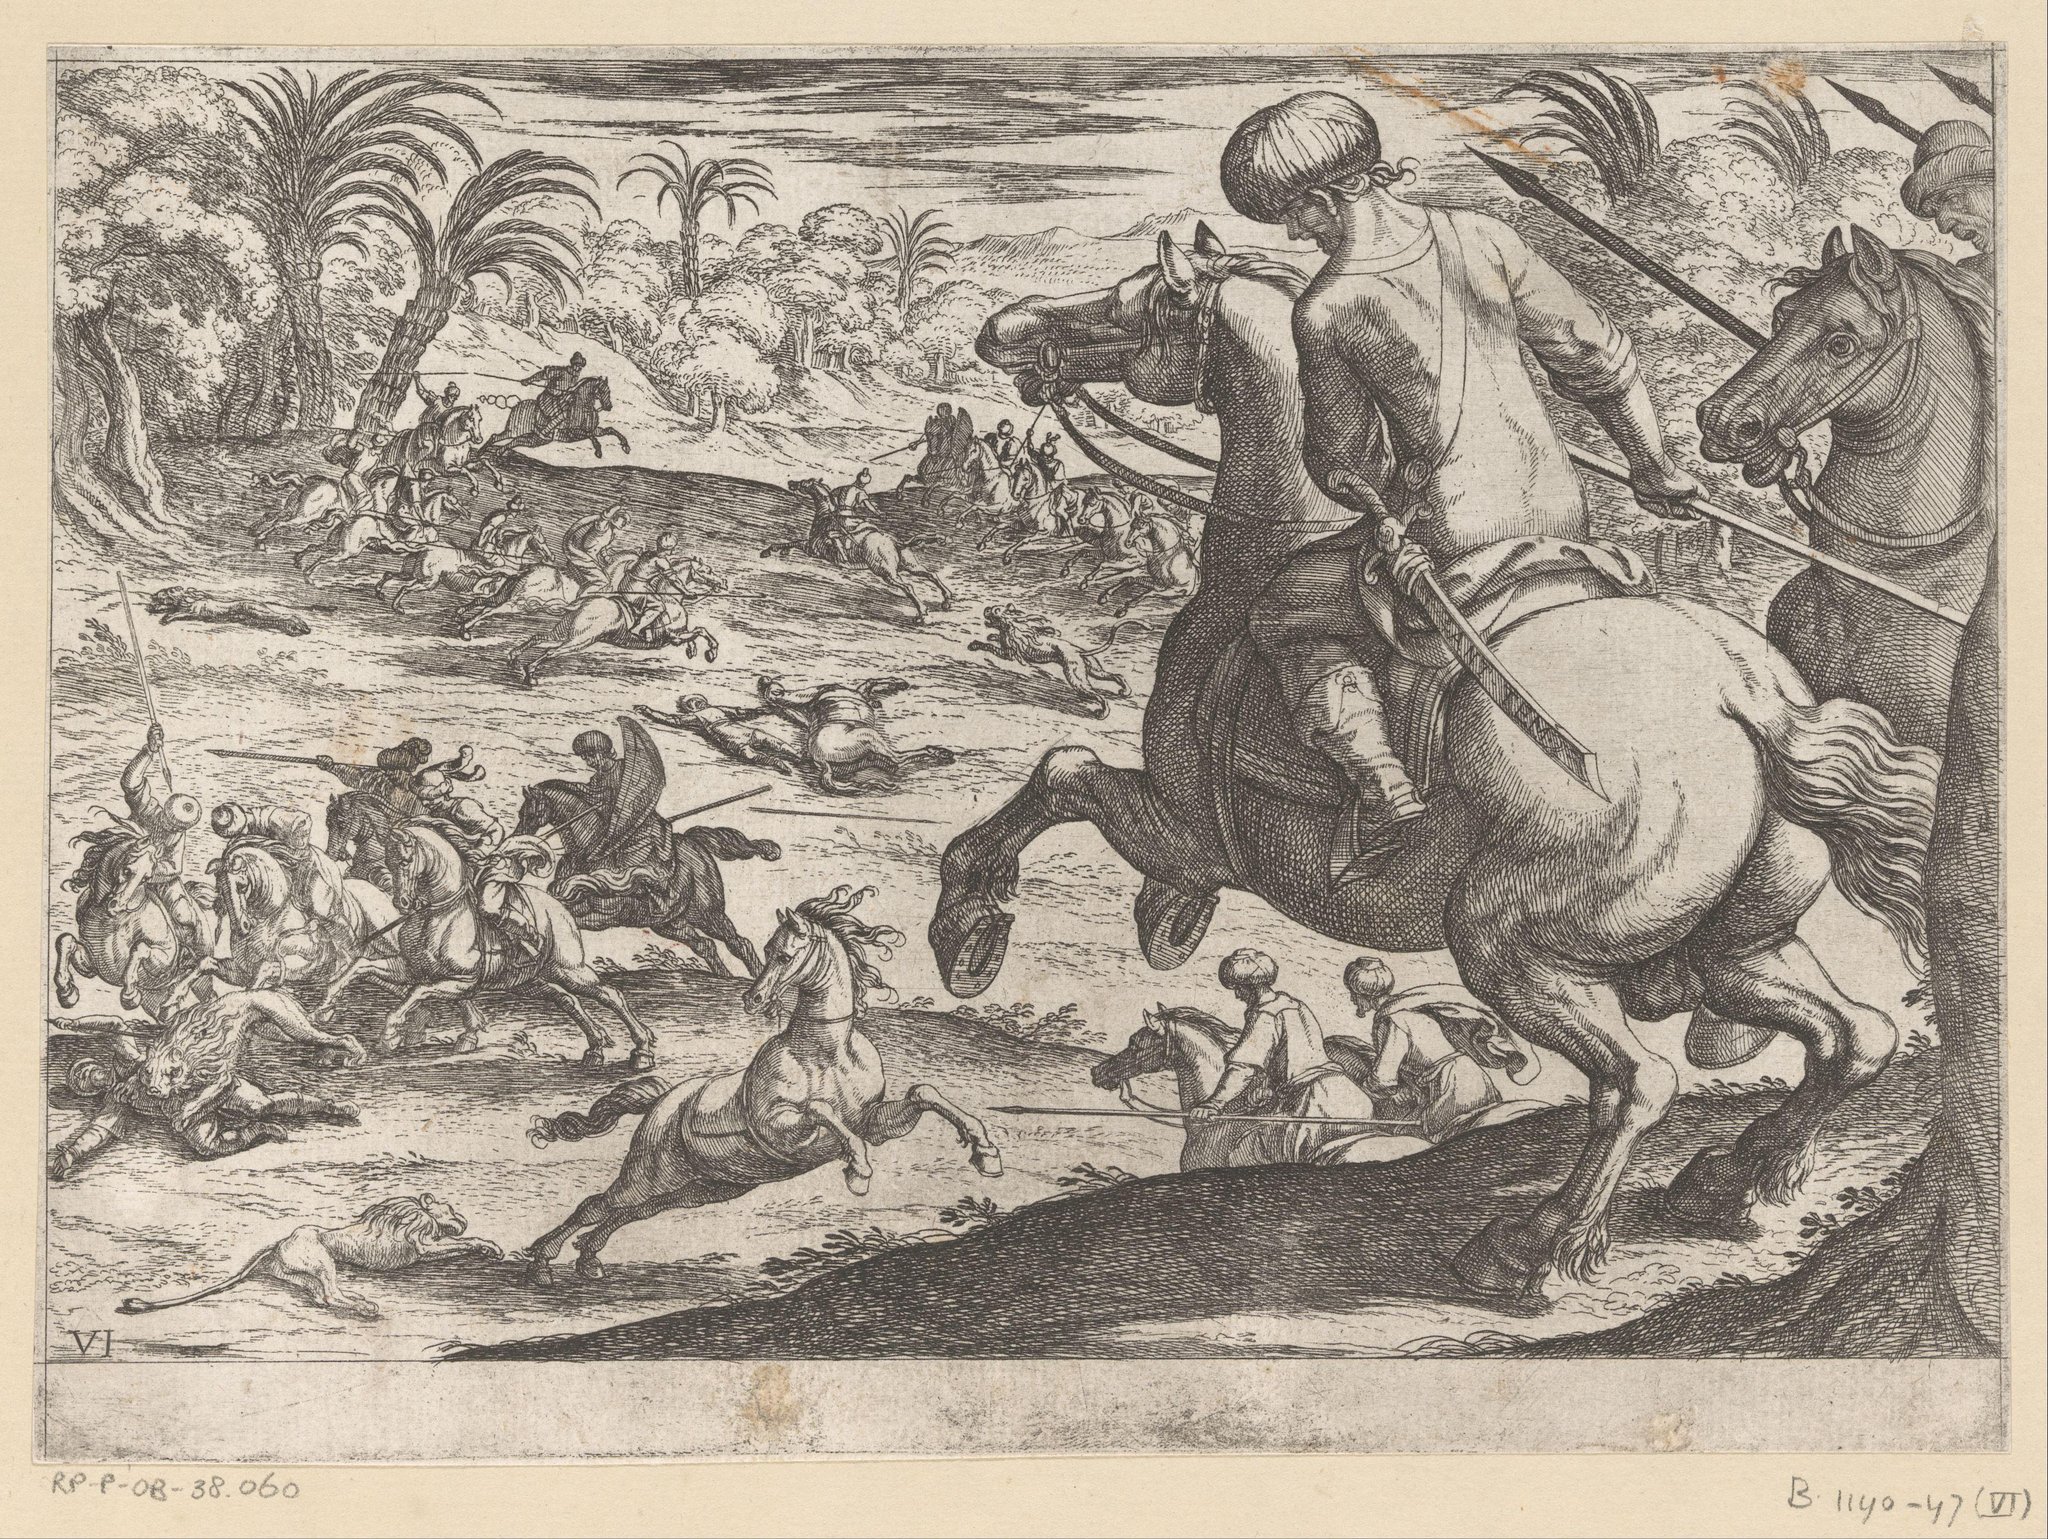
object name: print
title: Jachtscènes (deel 6)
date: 1609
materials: paper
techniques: etching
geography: rome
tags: lion hunt, hunter, hunters hunting (n.b.: in 1988-1990 this notation denoted the concept of 43c11421 'hunters resting during the hunt')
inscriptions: collector's mark: Lugt 240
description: Deze prent maakt deel uit van een reeks van negen prenten met jachtscènes (+ opdracht).